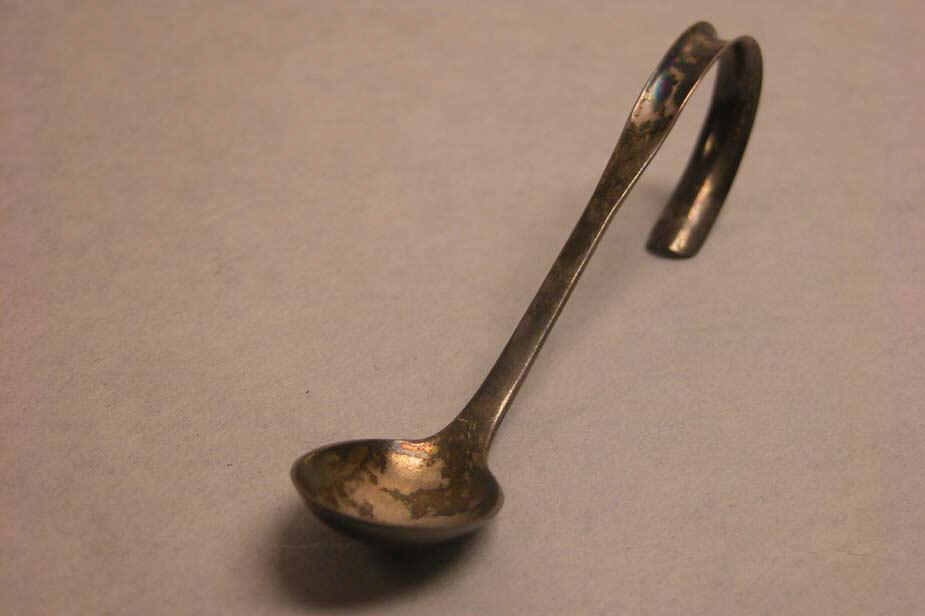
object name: spoon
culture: japanese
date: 1801-1900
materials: silver